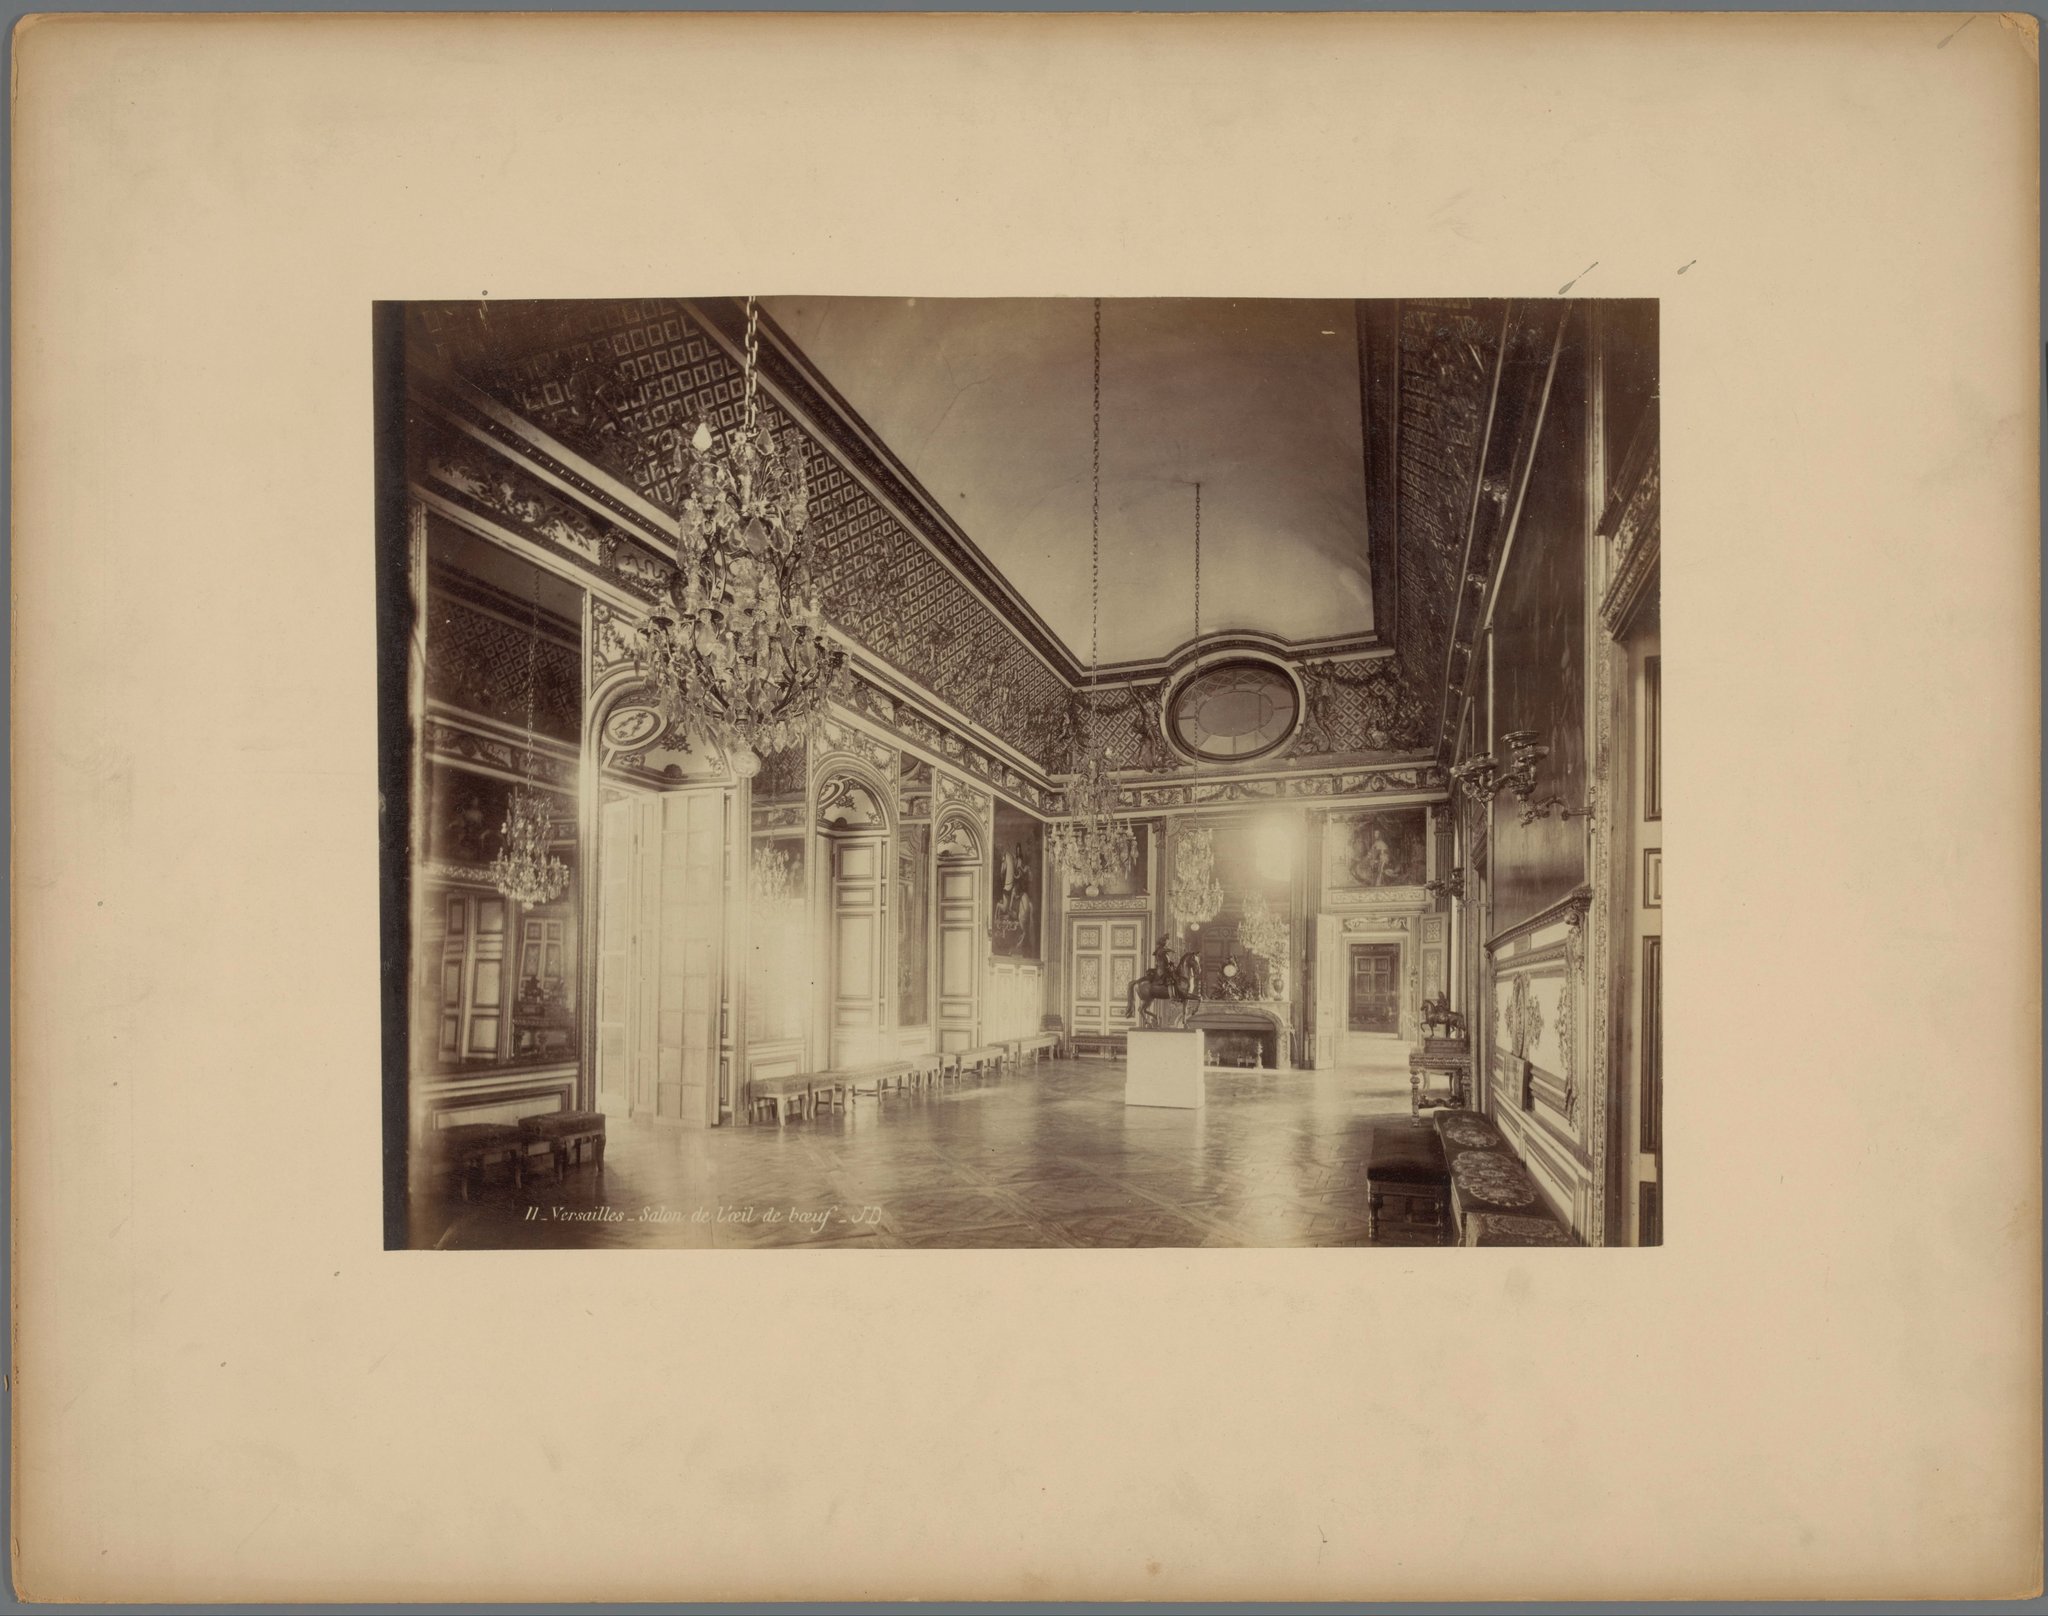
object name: photograph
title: Cabinet du Conseil in het Paleis van Versailles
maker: jd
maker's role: fotograaf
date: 1875-1900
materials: cardboard, photographic support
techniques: albumen print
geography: versailles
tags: mirror, chandelier, candelabrum, palace, interior of the house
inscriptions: collector's mark: Lugt 3937, number: ‘14.’